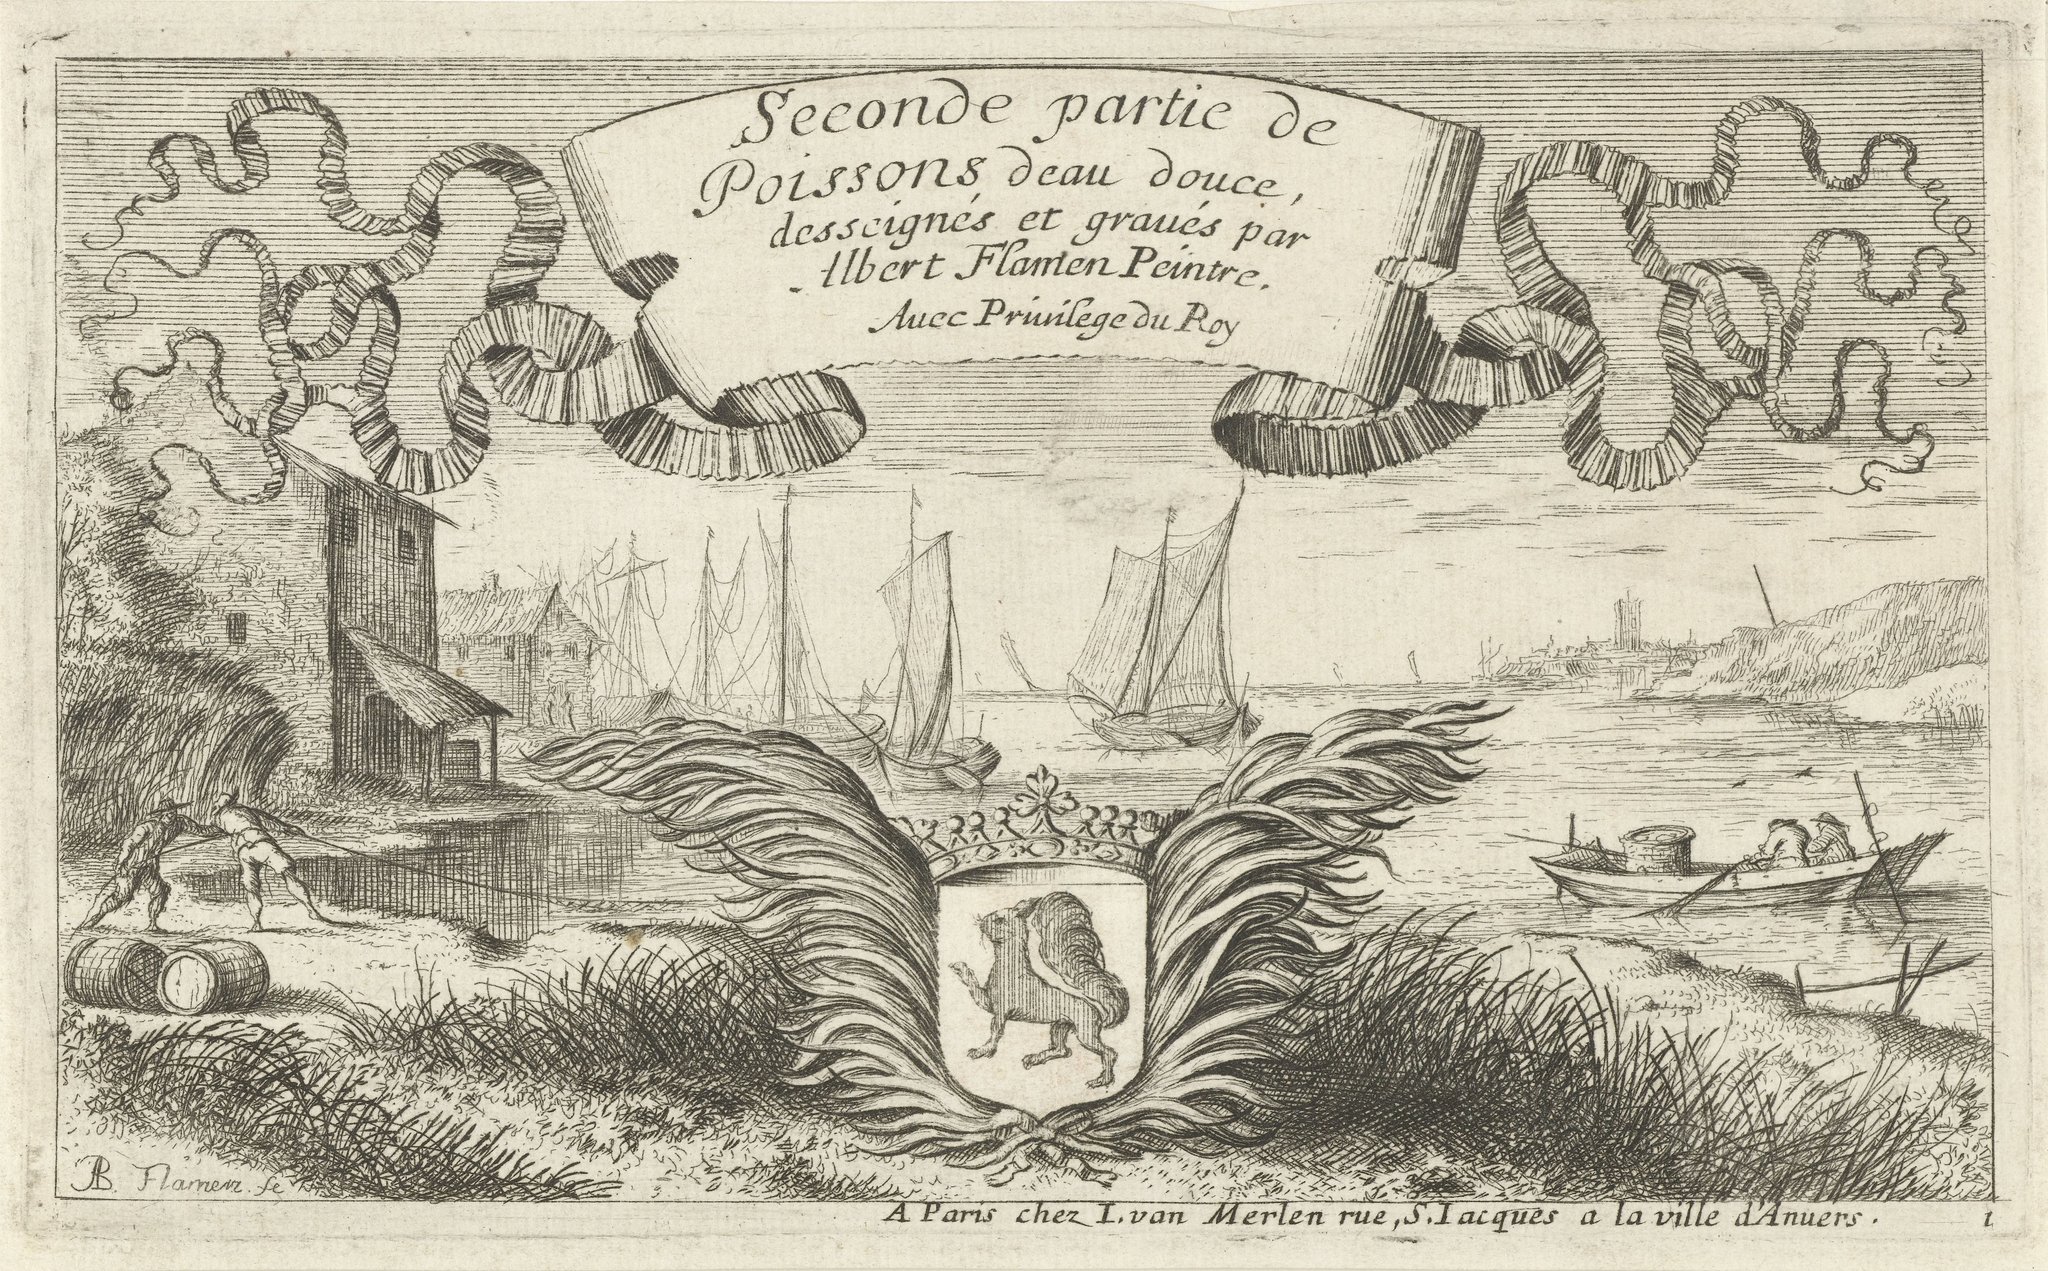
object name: print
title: Seconde partie de Poissons d'eau douce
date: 1664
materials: paper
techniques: etching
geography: paris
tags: river (+ landscape with figures, staffage)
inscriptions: collector's mark: Lugt 2228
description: Rivierlandschap met op de voorgrond het wapen van Nicolas Foucquet, tussen twee palmtakken. Op de rivier verschillende boten en langs de oever enkele huizen. Bovenaan een cartouche met Franse tekst met serietitel en vervaardigersnamen. Titelprent voor de tweede zoetwater reeks van vijf reeksen met verschillende vissoorten en andere zeedieren.